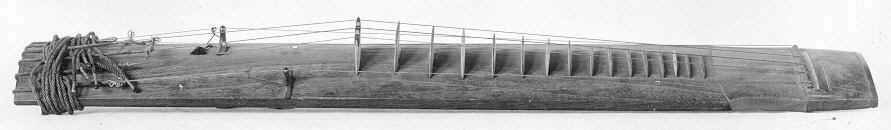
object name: geomungo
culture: korean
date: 1867-1900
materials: bone, leather, plastic, silk, wood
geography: korea